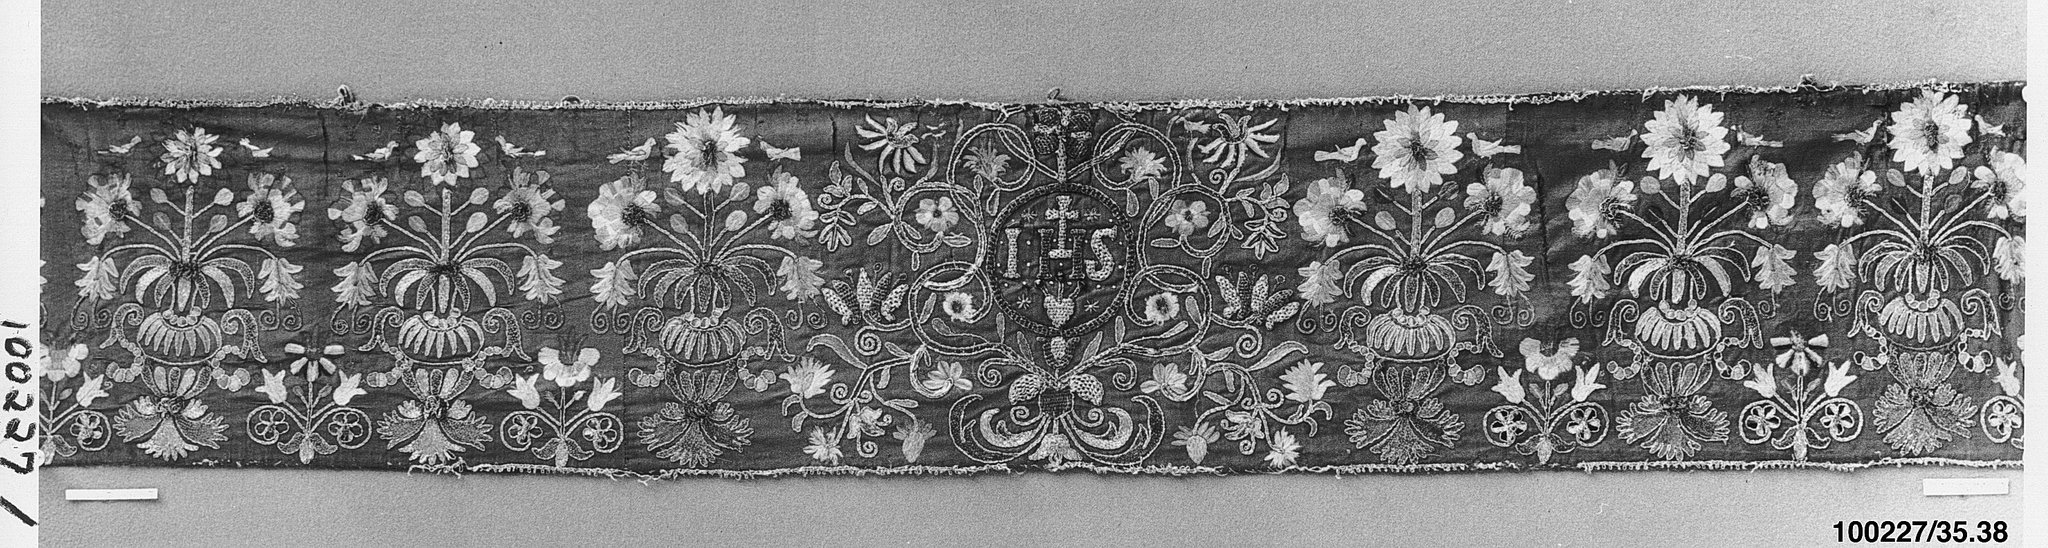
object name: border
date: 1589-1610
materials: metal thread, silk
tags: flowers,insignia